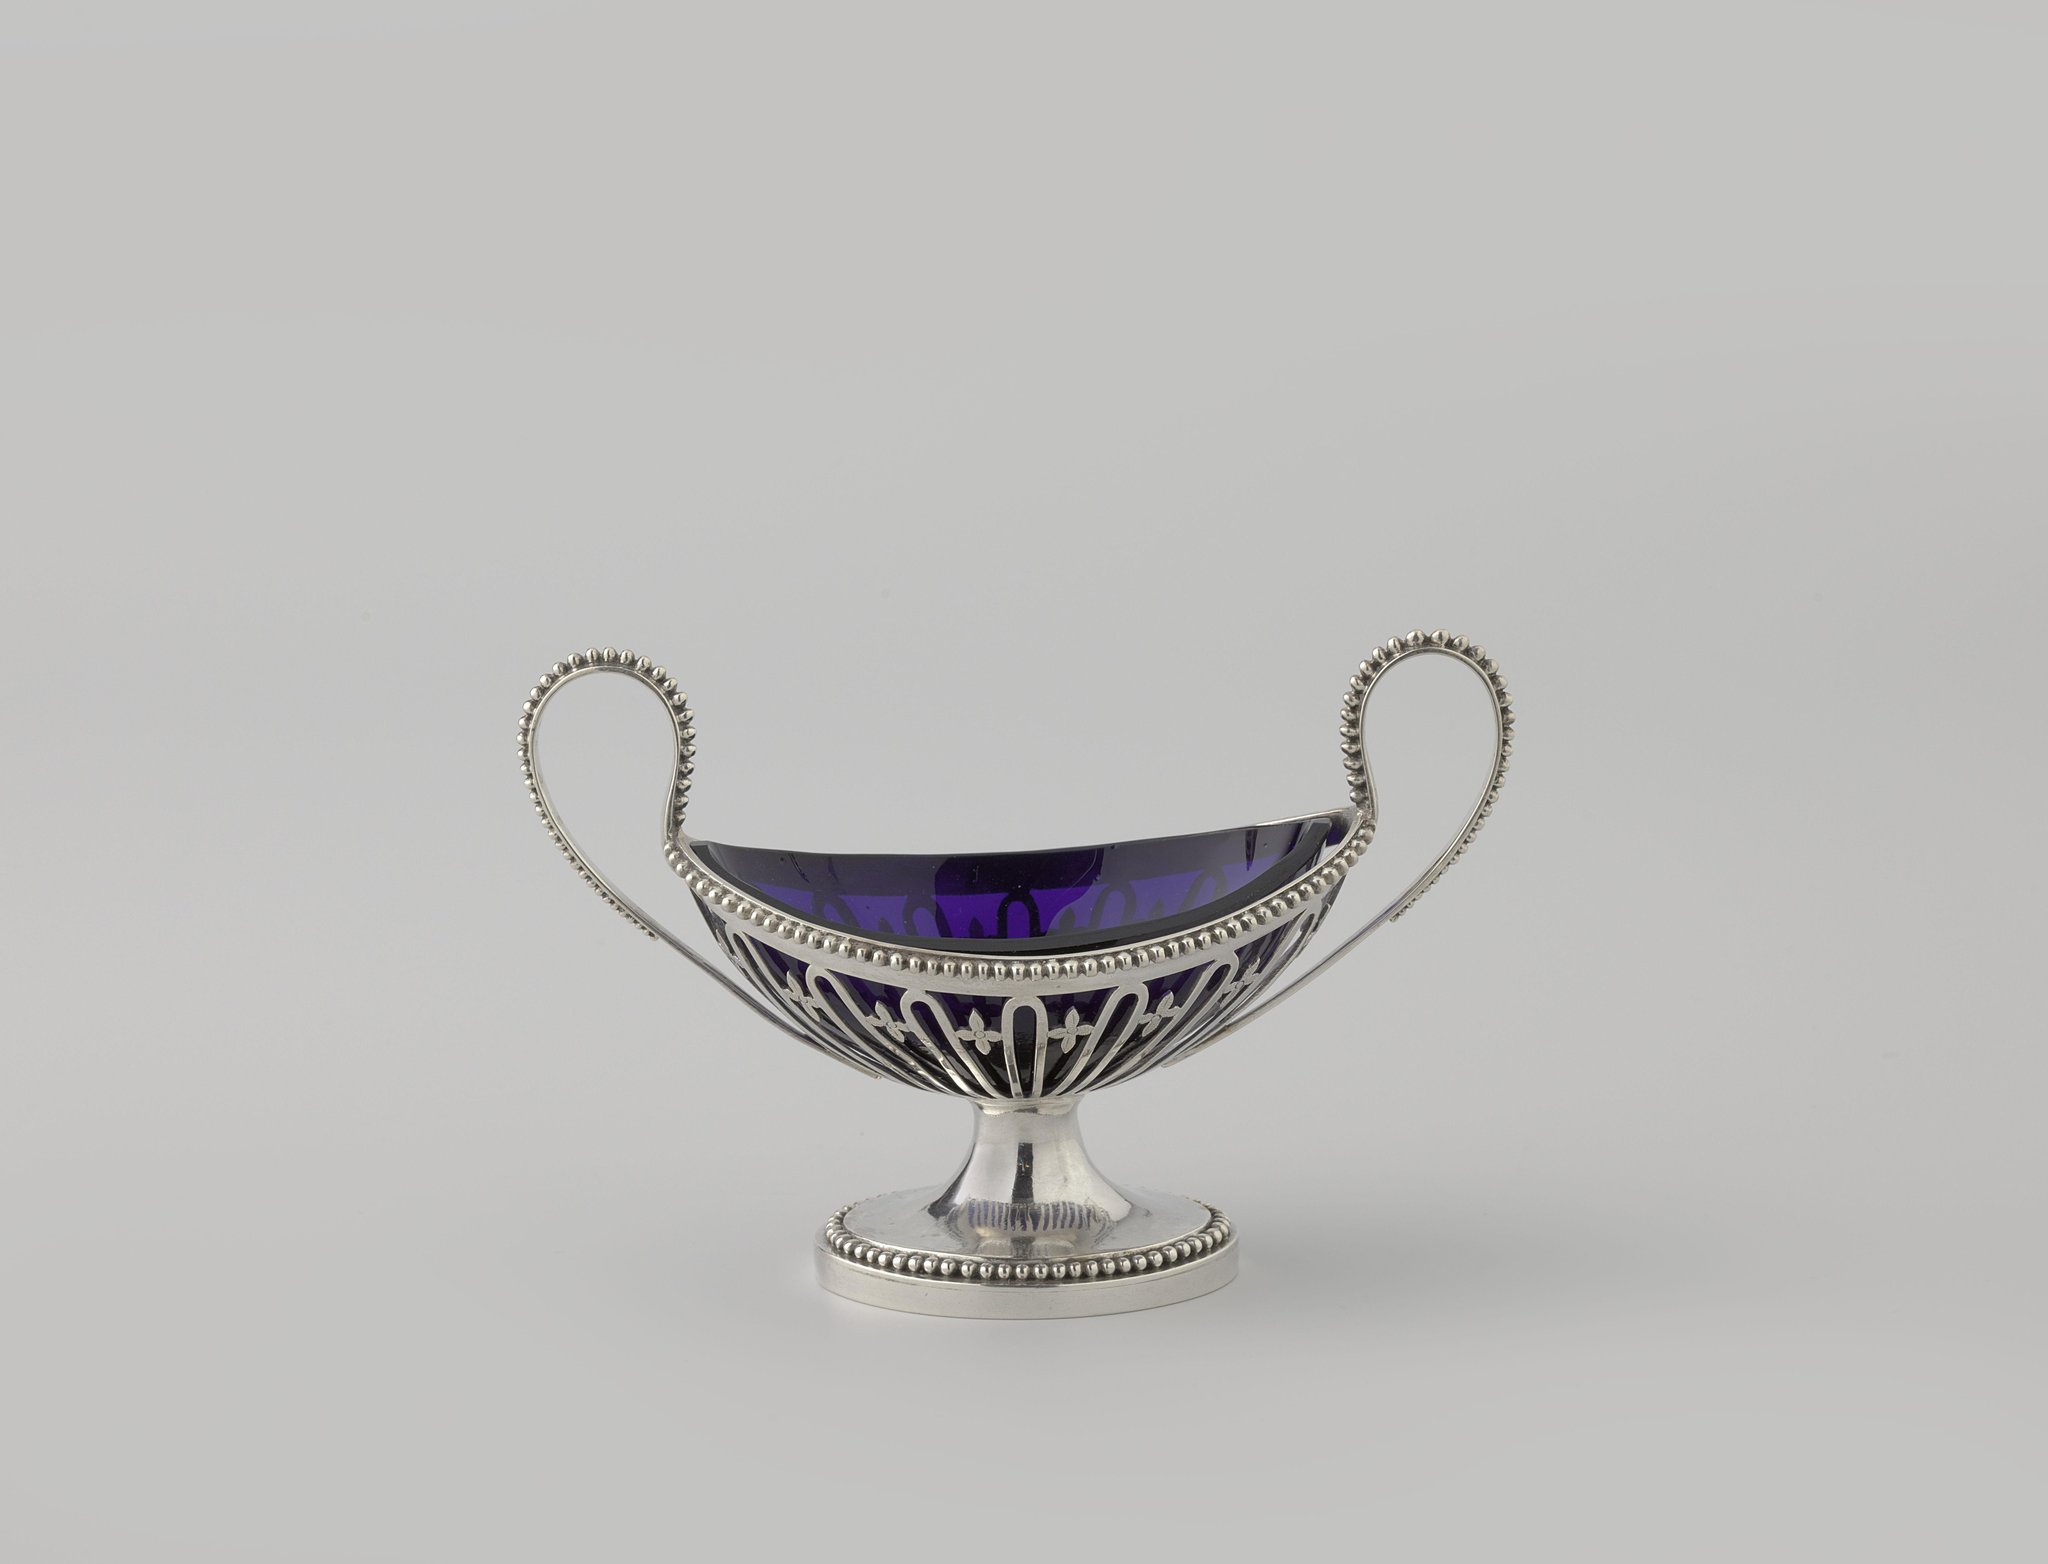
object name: salt condiment vessel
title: Zoutvat, spitsovaal, met opengewerkte wand met parellijsten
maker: nathanael teuter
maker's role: silversmith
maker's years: 1767-1831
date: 1805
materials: glass, silver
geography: amsterdam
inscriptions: maker's mark, alloy mark, town mark, duty mark, date letter: ‘W’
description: De spits ovale, gewelfde vaten (A, B,C en D), die aan de zijkanten iets verhoogde wanden hebben, rusten op een ovale, zich naar boven sterk verjongende voet met een rechtwandige basis. Het lichaam is opengewerkt met afwisselend knerren en rozetten. Rond de voet, rond de bovenrand van het lichaam en over de hoog oplopende, gebogen oren lopen parellijsten. In de vaatjes passen binnenbakjes van blauw glas, waarvan D met krammetjes is hersteld.